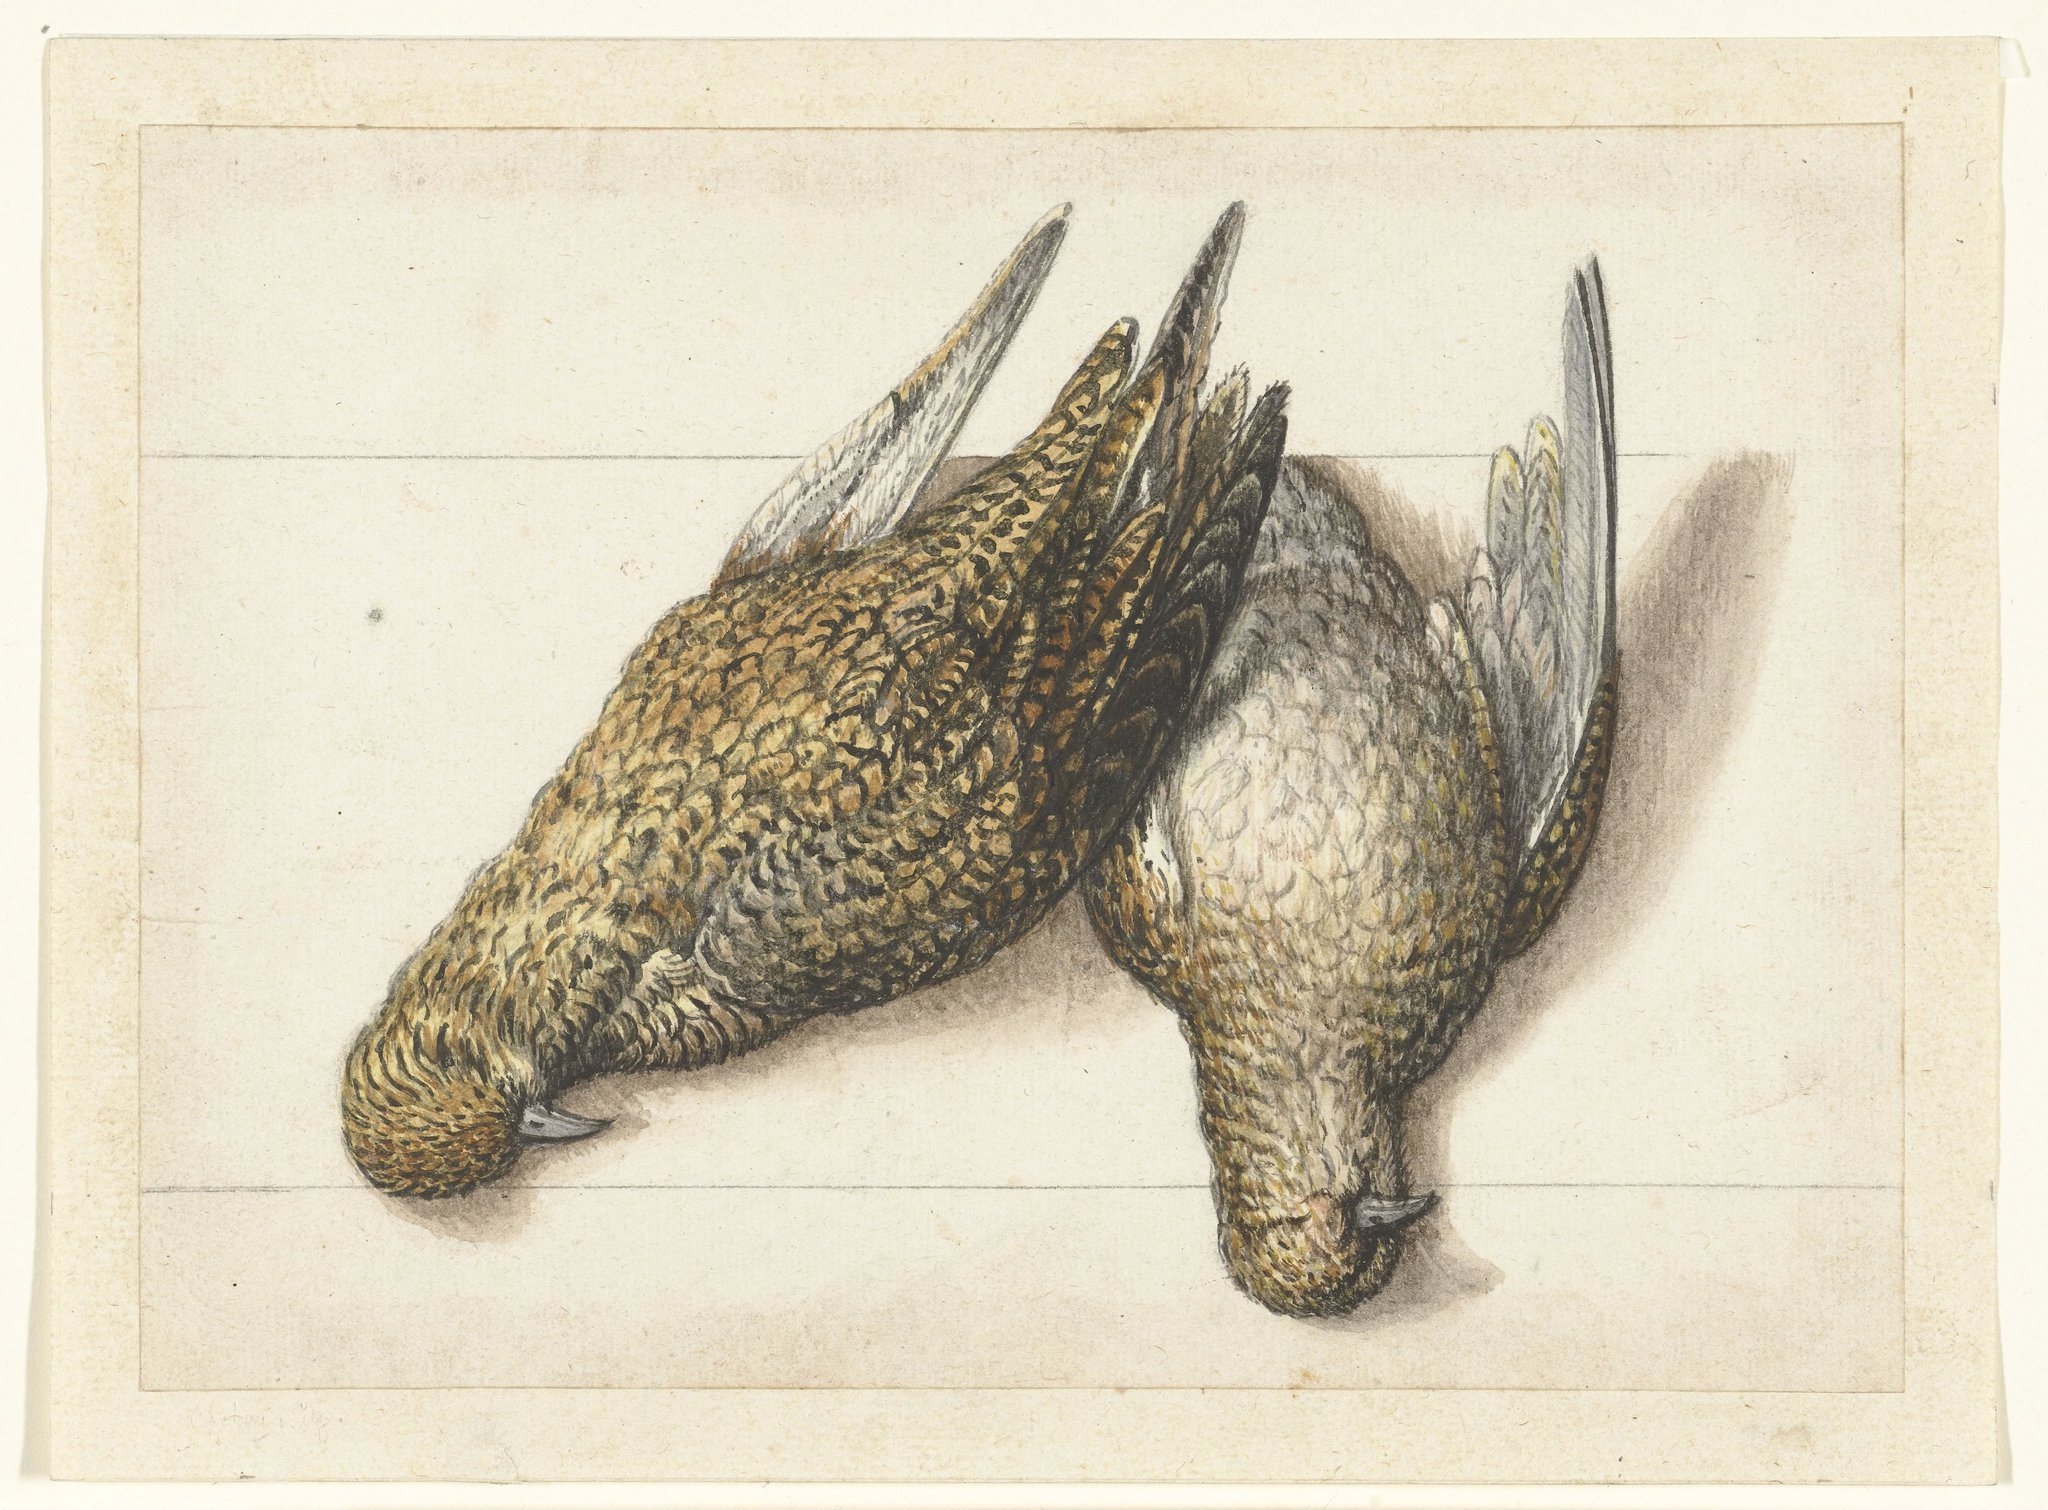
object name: drawing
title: Lombard album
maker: Anonymous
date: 1560-1585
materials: chalk, paint, paper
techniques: brush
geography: low countries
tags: birds, shore-birds and wading-birds: plover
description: Blad uit album van 100 (?) bladen met tekeningen van dieren.